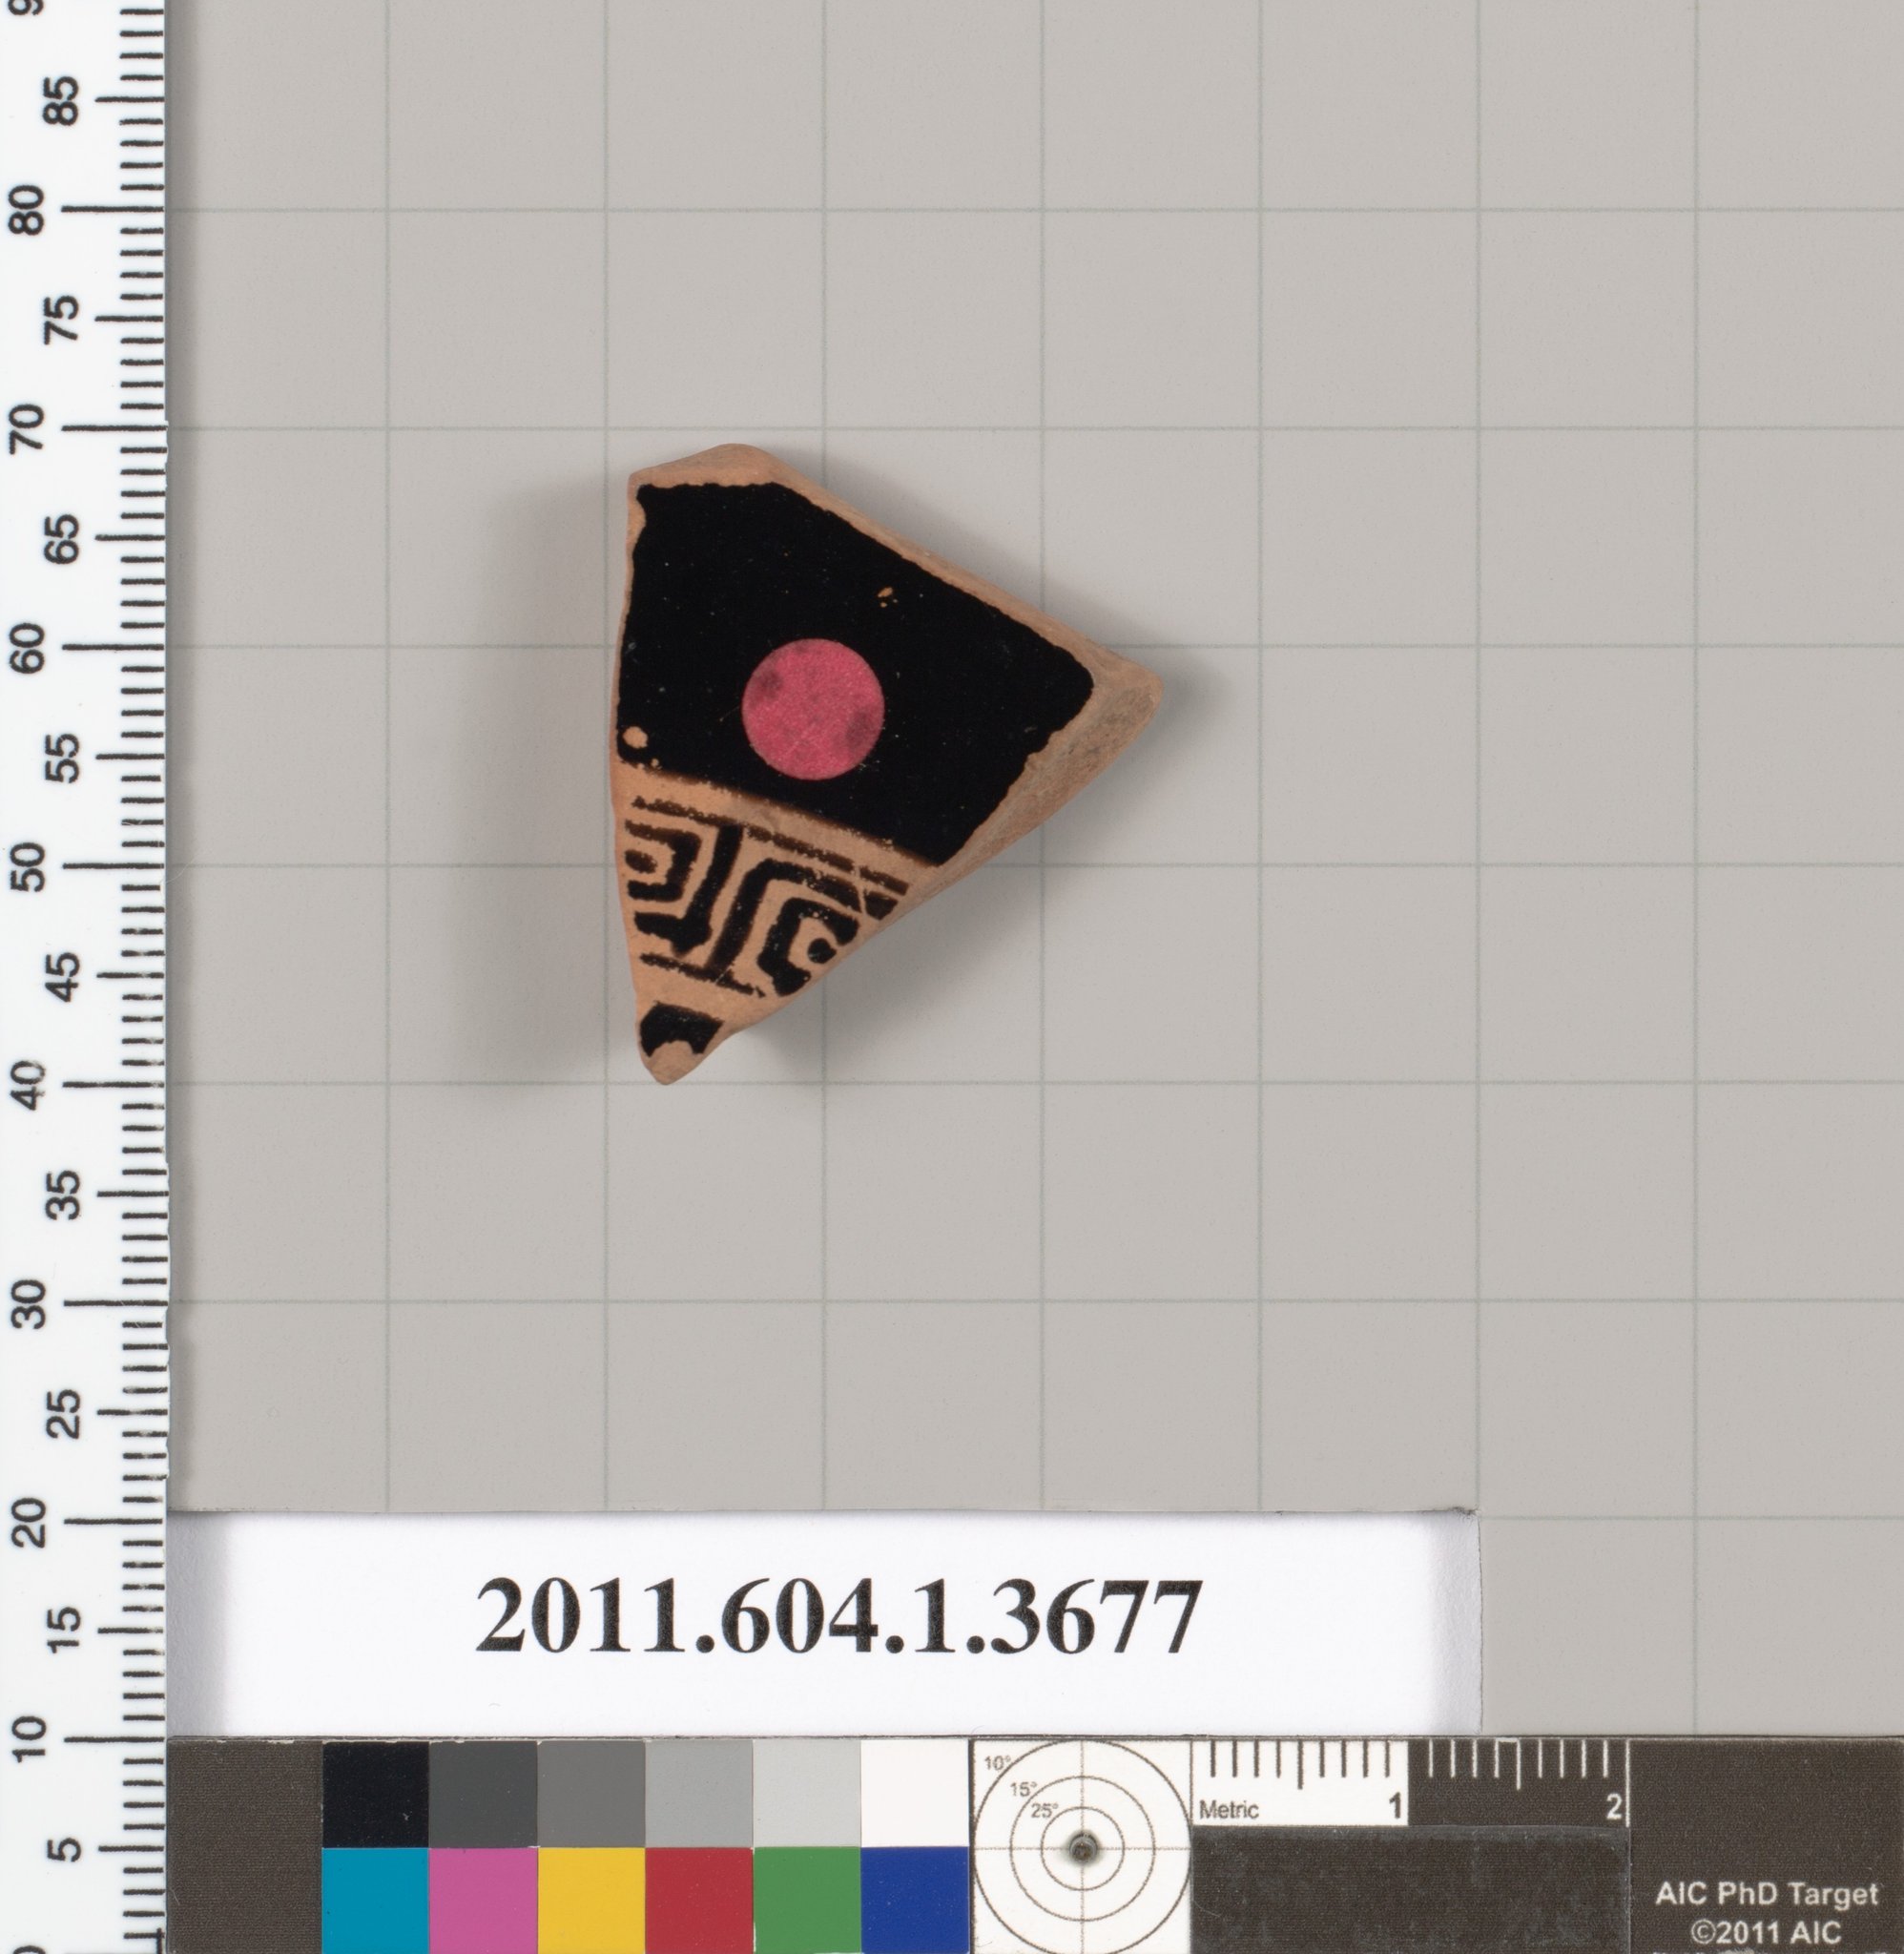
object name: kylix fragment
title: Terracotta fragment of a kylix (drinking cup)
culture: greek, attic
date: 475-451 BCE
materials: terracotta